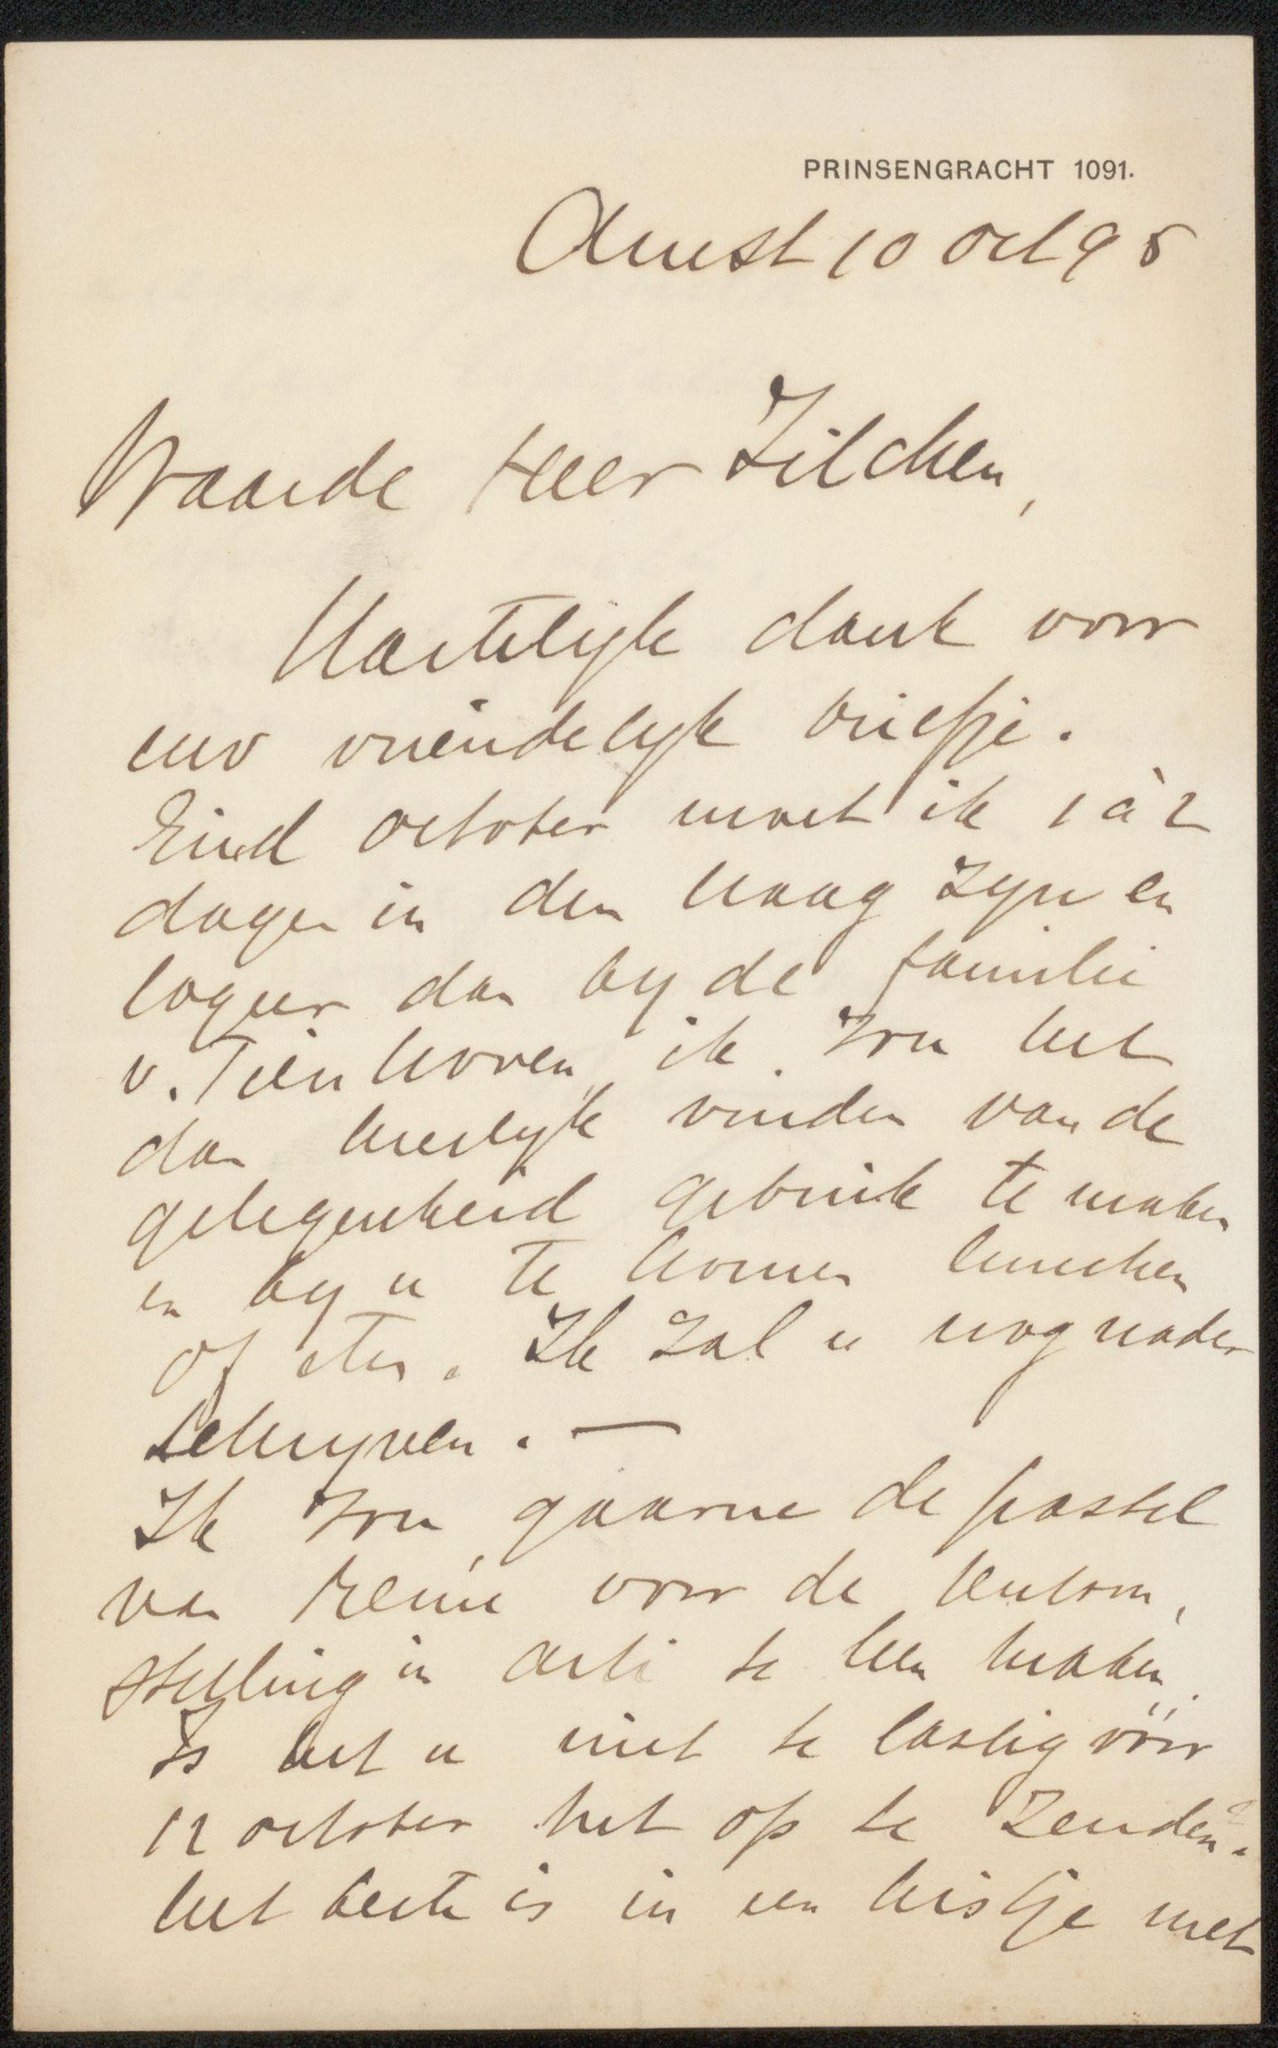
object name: letter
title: Brief aan Philip Zilcken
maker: thérèse schwartze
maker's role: draughtsman, painter, print maker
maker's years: 1851-1918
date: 1895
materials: ink, paper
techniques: pen, printing, writing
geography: amsterdam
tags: mayor, gijsbert van tienhoven, the hague, painter, philip zilcken, exhibition ~ art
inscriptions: watermark, collector's mark: ‘RPK’